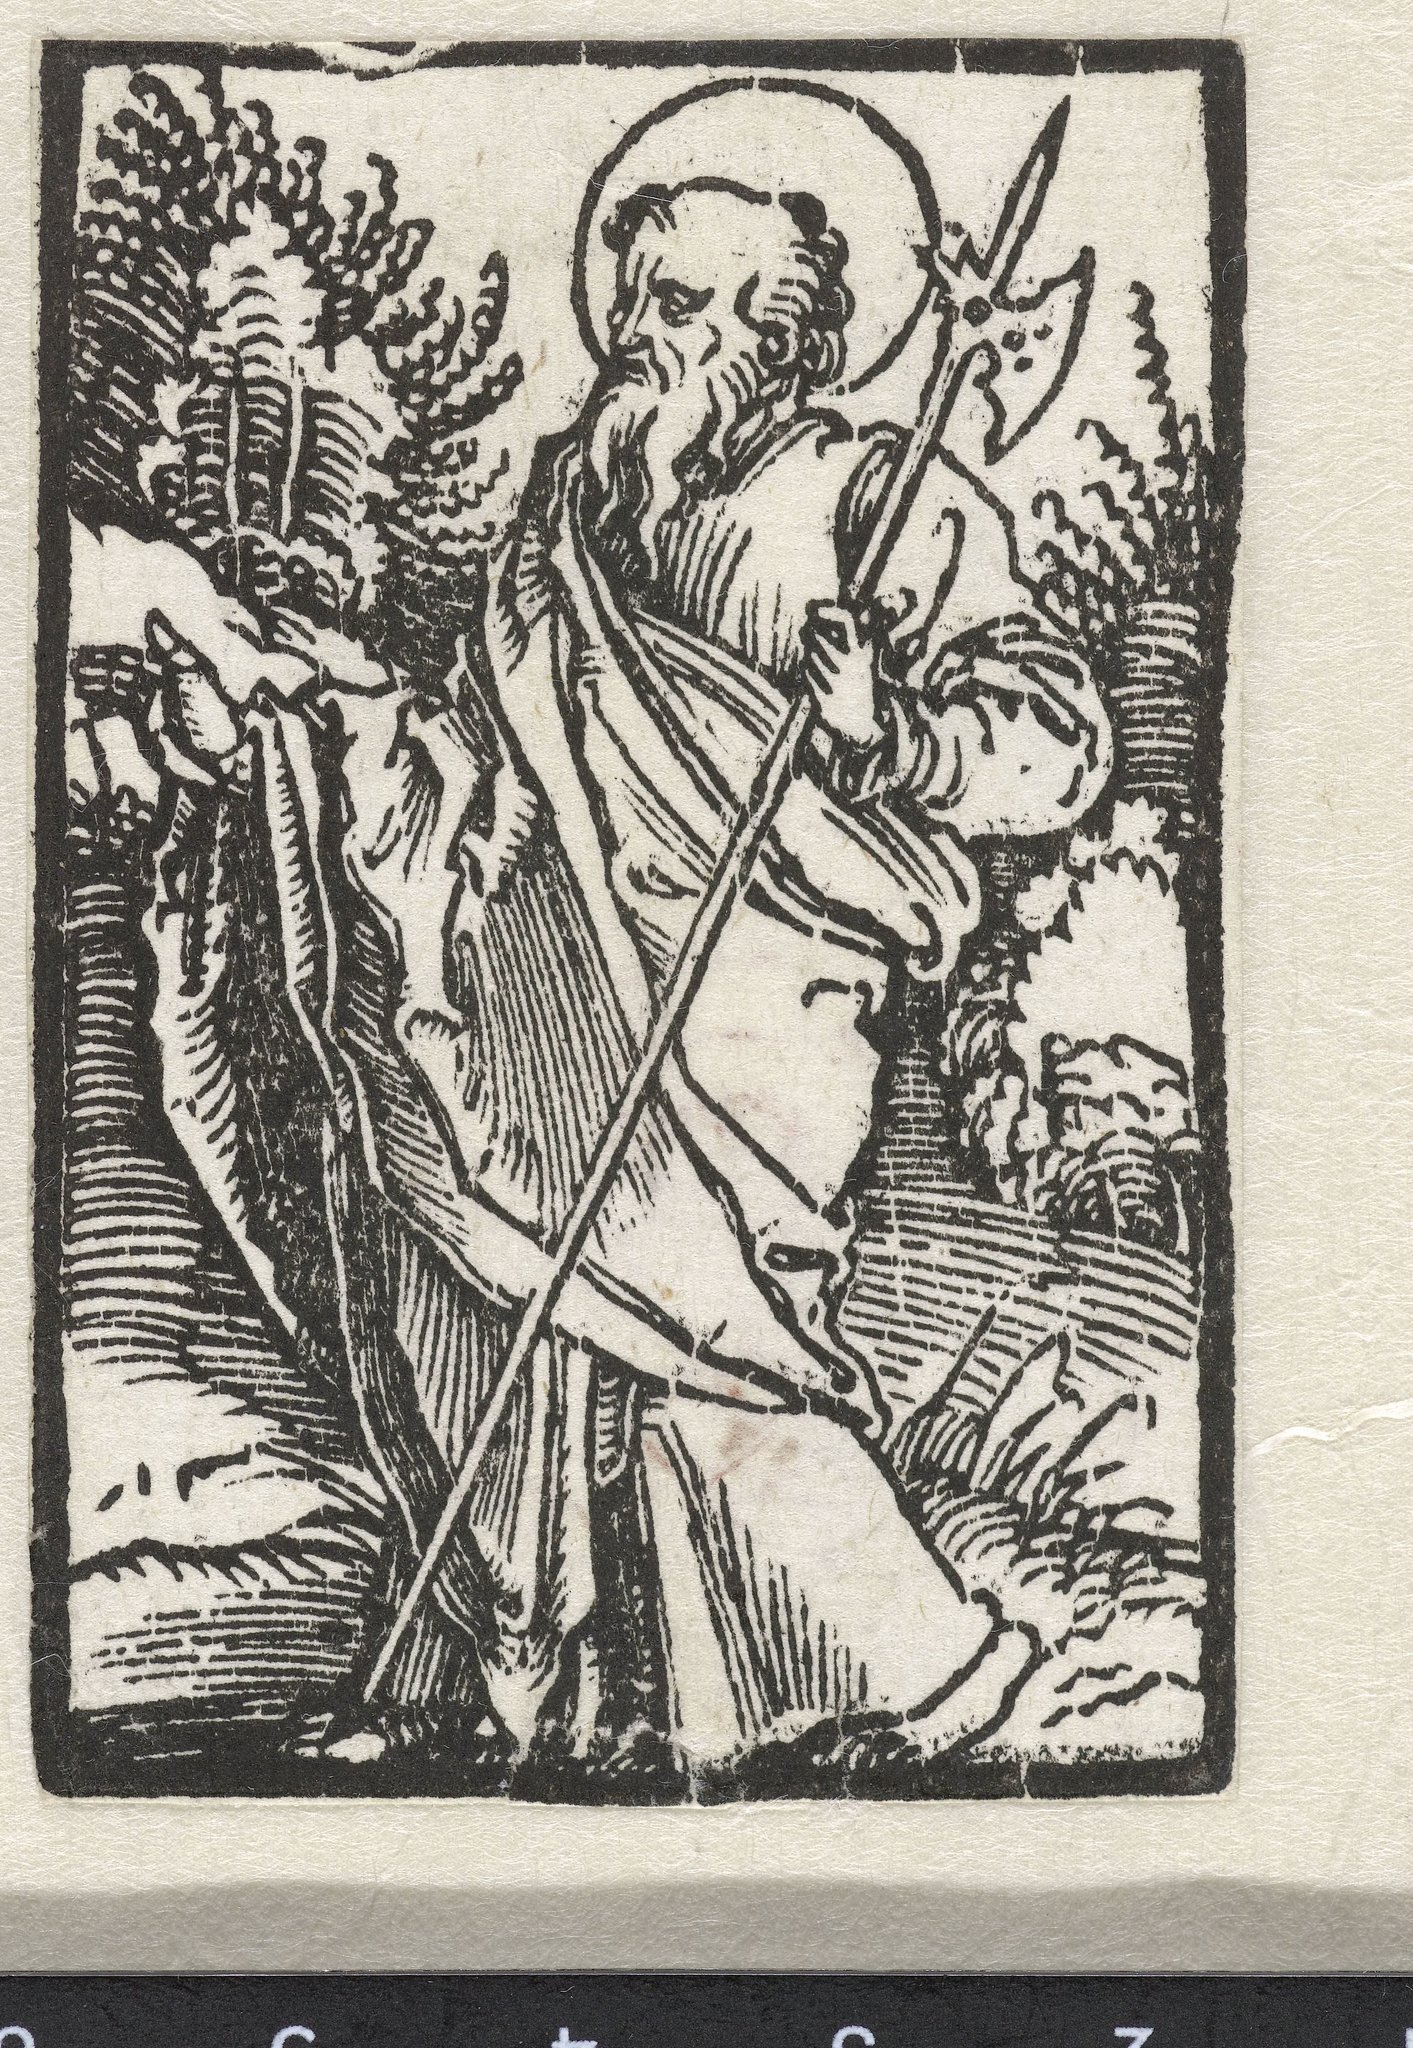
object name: book illustration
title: Apostel Mattheüs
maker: albrecht dürer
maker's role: draughtsman, painter, print maker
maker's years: 1471-1528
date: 1503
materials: paper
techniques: woodcut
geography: nuremberg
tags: the apostle and evangelist matthew (mattheus); possible attributes: angel, axe, book, halberd, pen and inkhorn, purse, scroll, square, sword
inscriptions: collector's mark: Lugt 240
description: Illustratie voor: Salus anim[a]e, Neurenberg: Hieronymus Höltzel, 1503. Klinkert, C.